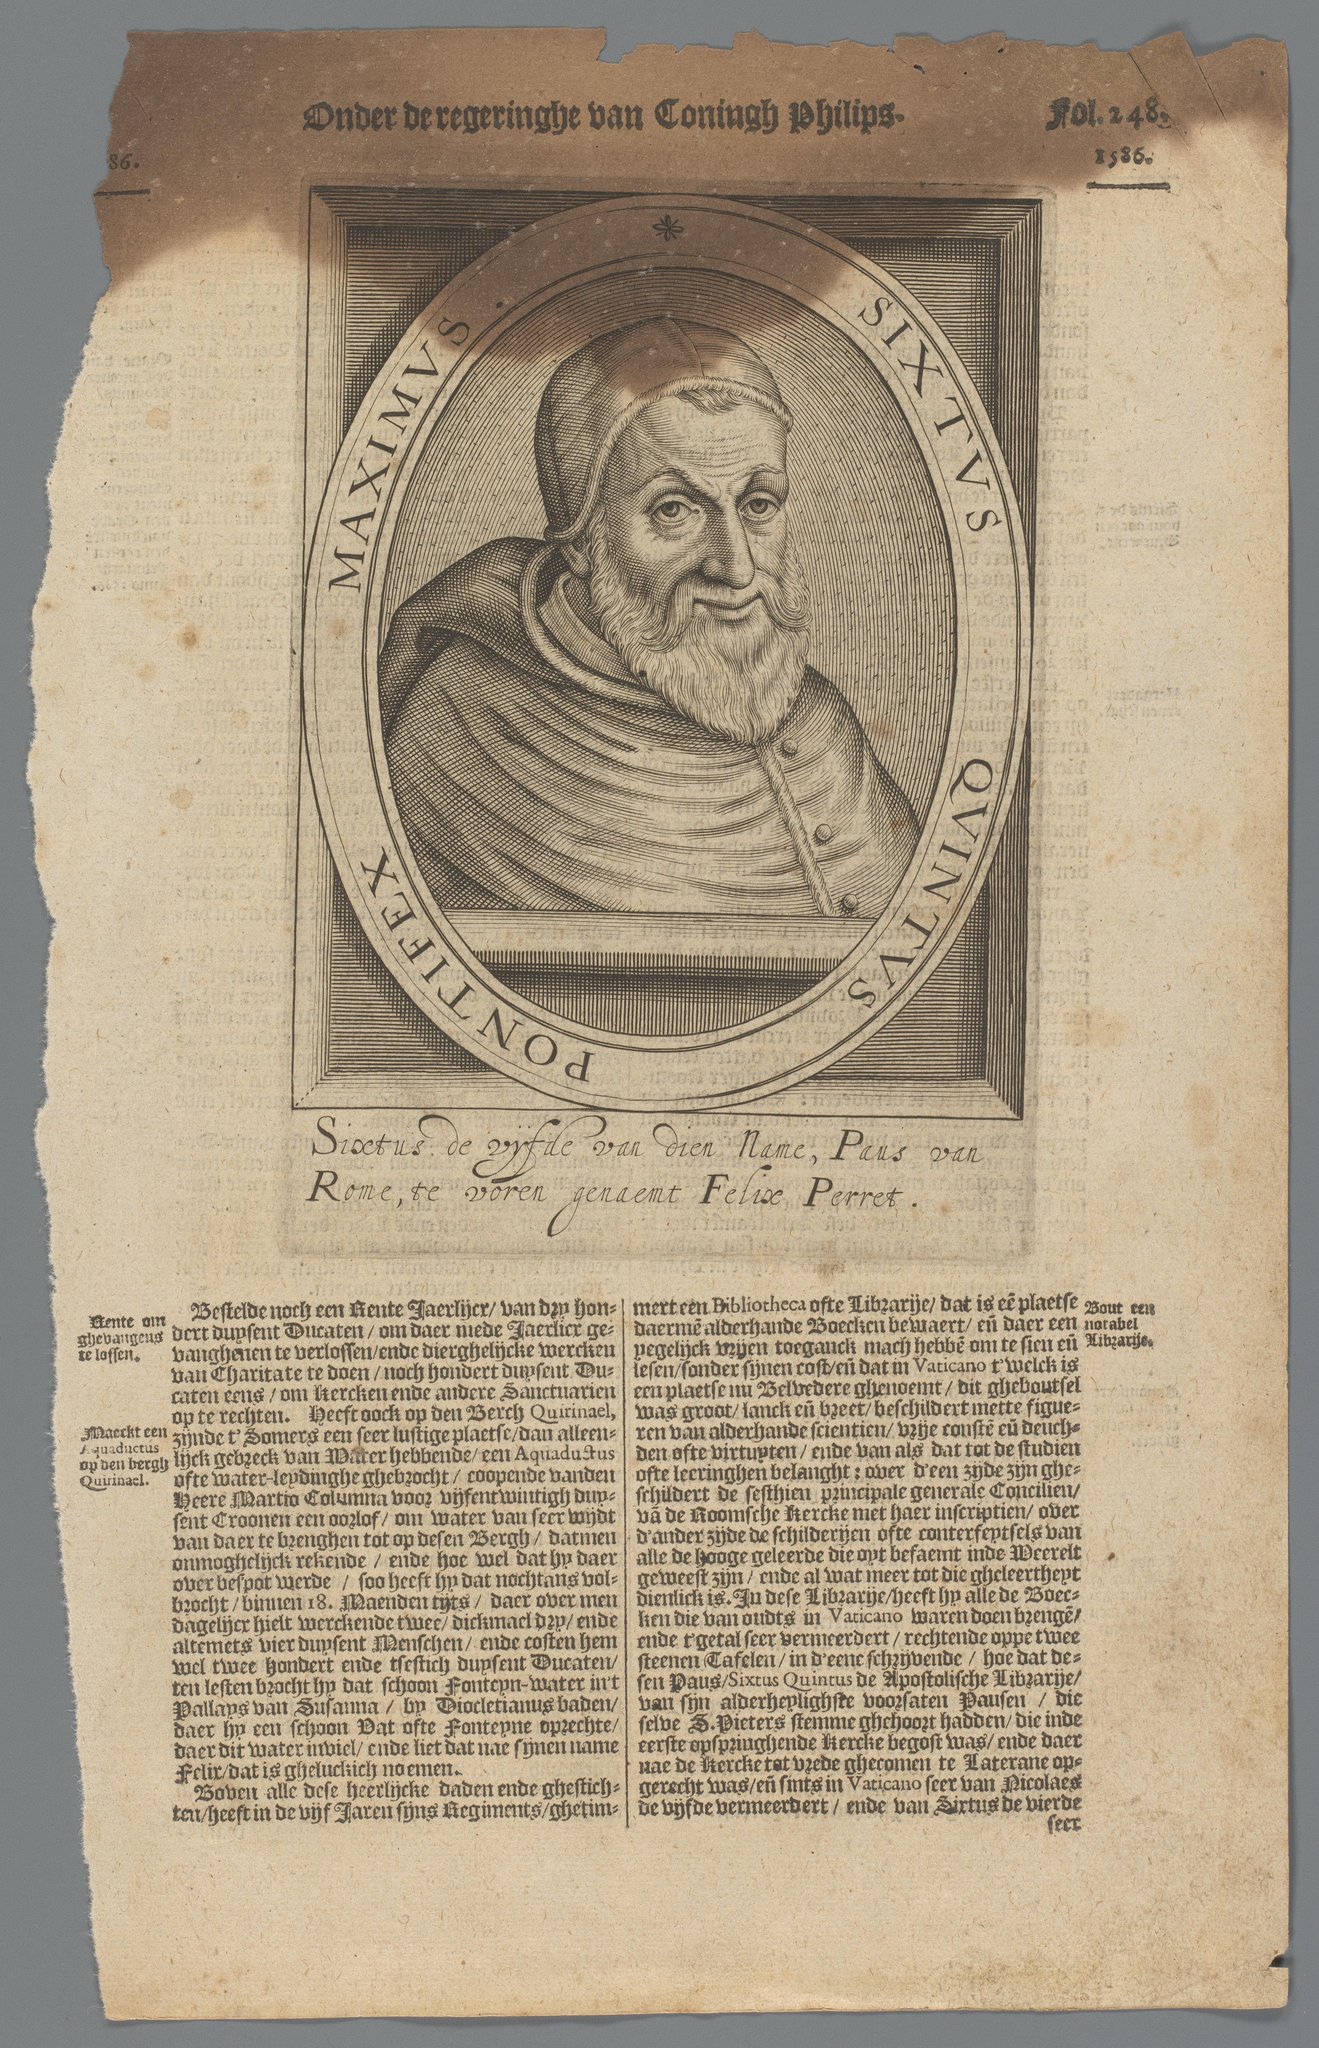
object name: book illustration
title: Portret van paus Sixtus V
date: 1614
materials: paper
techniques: engraving, letterpress printing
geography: the hague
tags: rome, sixtus v, historical persons, pope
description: Prent uit: Meteren, Emanuel van. Historie der Nederlandscher ende haerder na-buren oorlogen ende geschiedenissen (...). Den Haag: Hillebrant Iacobsz. van Wouw, 1614. Prent ook gebruikt in: Meteren, Emanuel van. Historie der Nederlandscher ende haerder na-buren oorlogen ende geschiedenissen (...). Den Haag: weduwe en erfgenamen van Hillebrant Iacobsz. van Wouw, 1623.